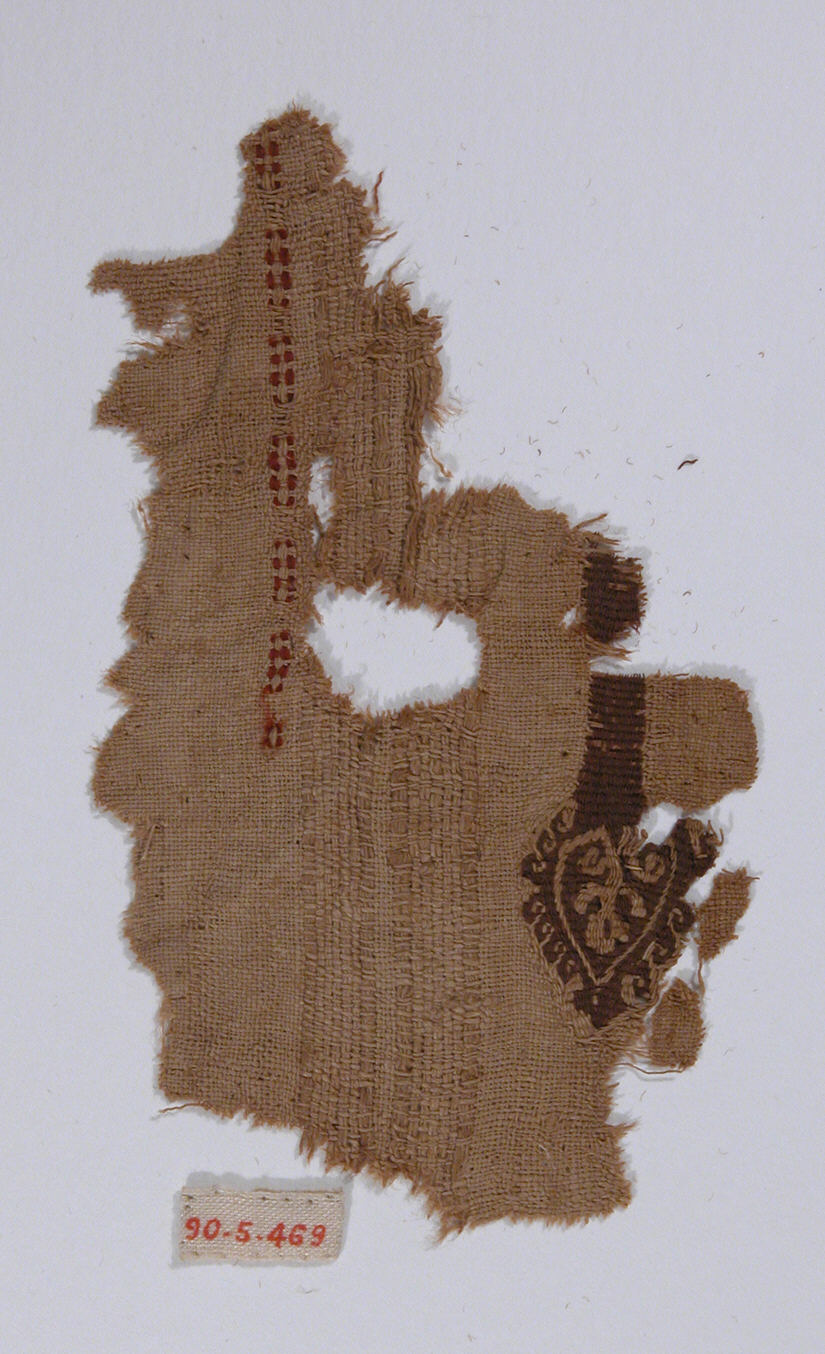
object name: textile fragment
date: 201-400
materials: linen, wool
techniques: weave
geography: egypt